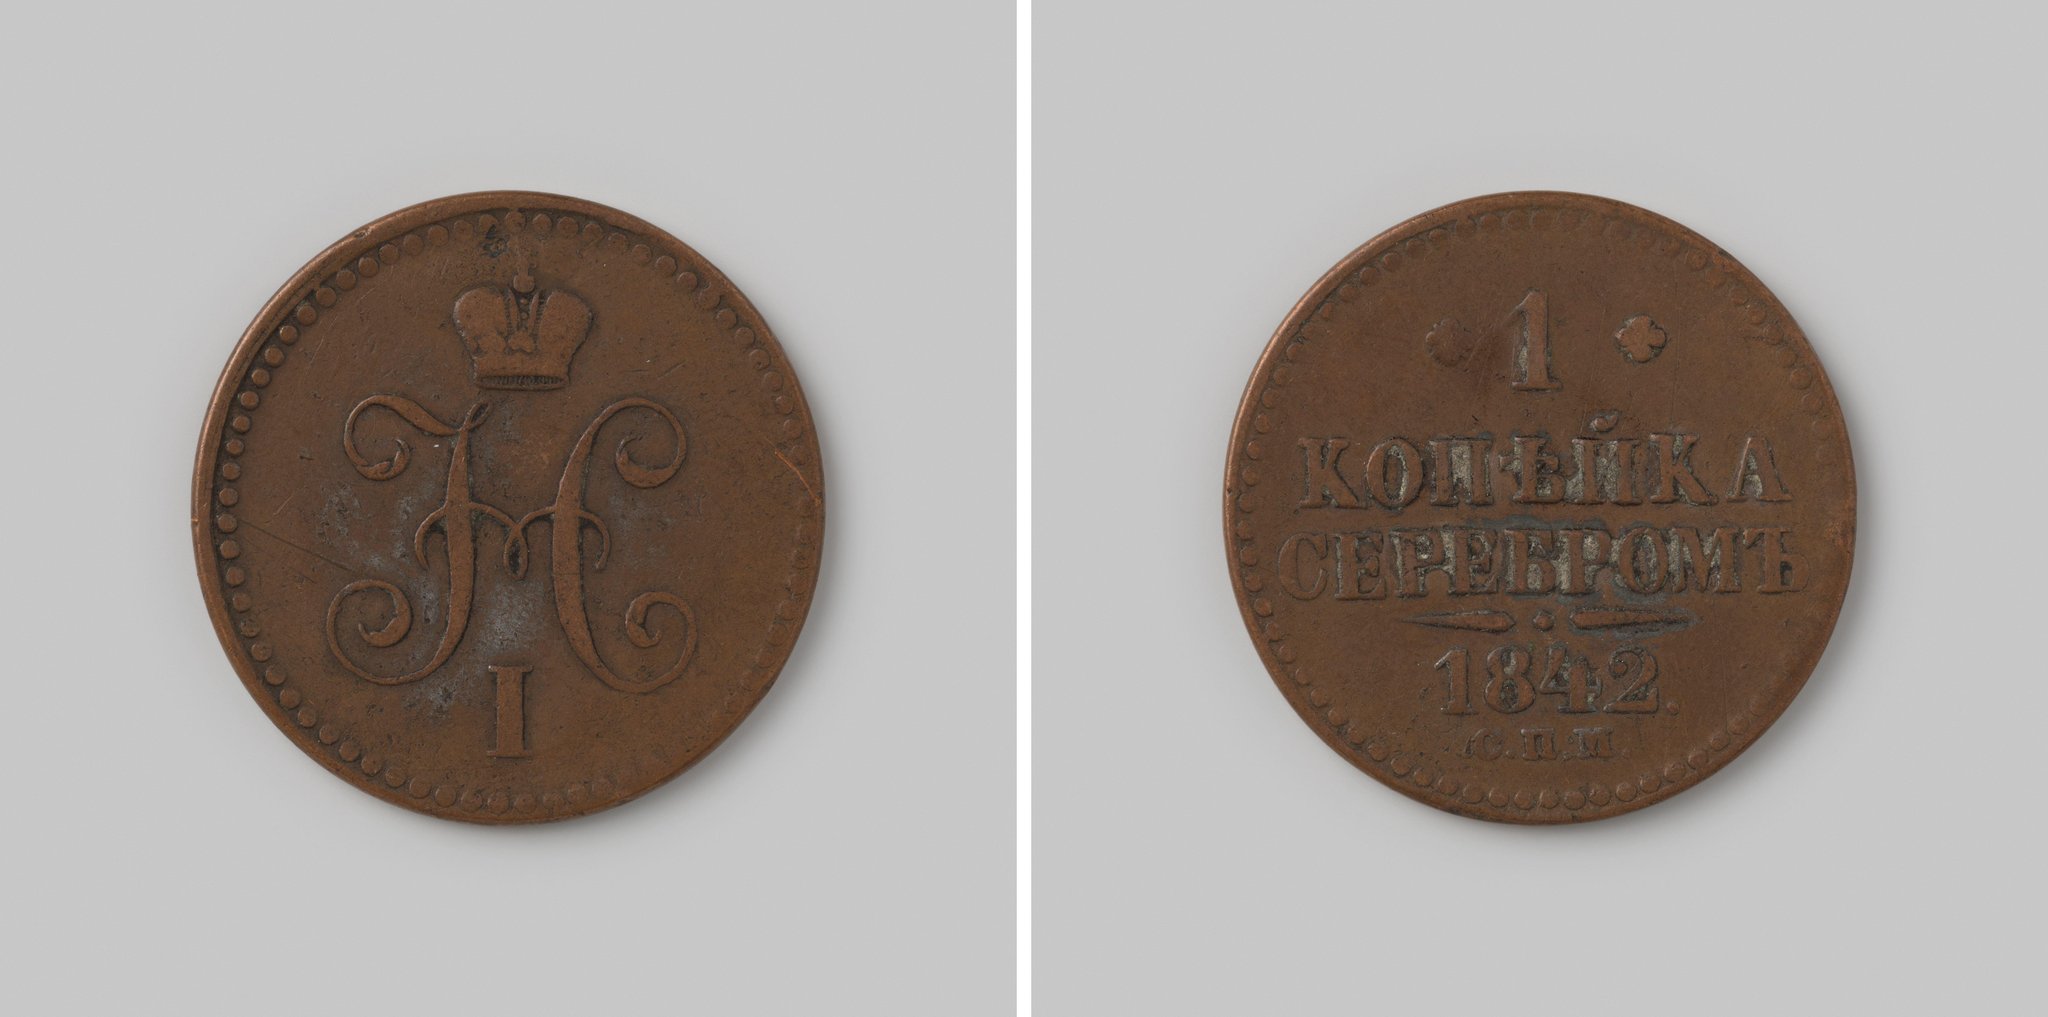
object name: coin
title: Rusland, tsaar Nikolai I, kopek, 1842 SPB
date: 1842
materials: copper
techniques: striking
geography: sint-petersburg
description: Koperen munt. Voorzijde: gekroond monogram van Nicolai I in het cyrillisch. Keerzijde: in drie regels waarde-aanduiding. Daaronder jaartal, waaronder in het Cyrillisch de letters S,P en B [=Sint Petersburg]. Gladde rand.